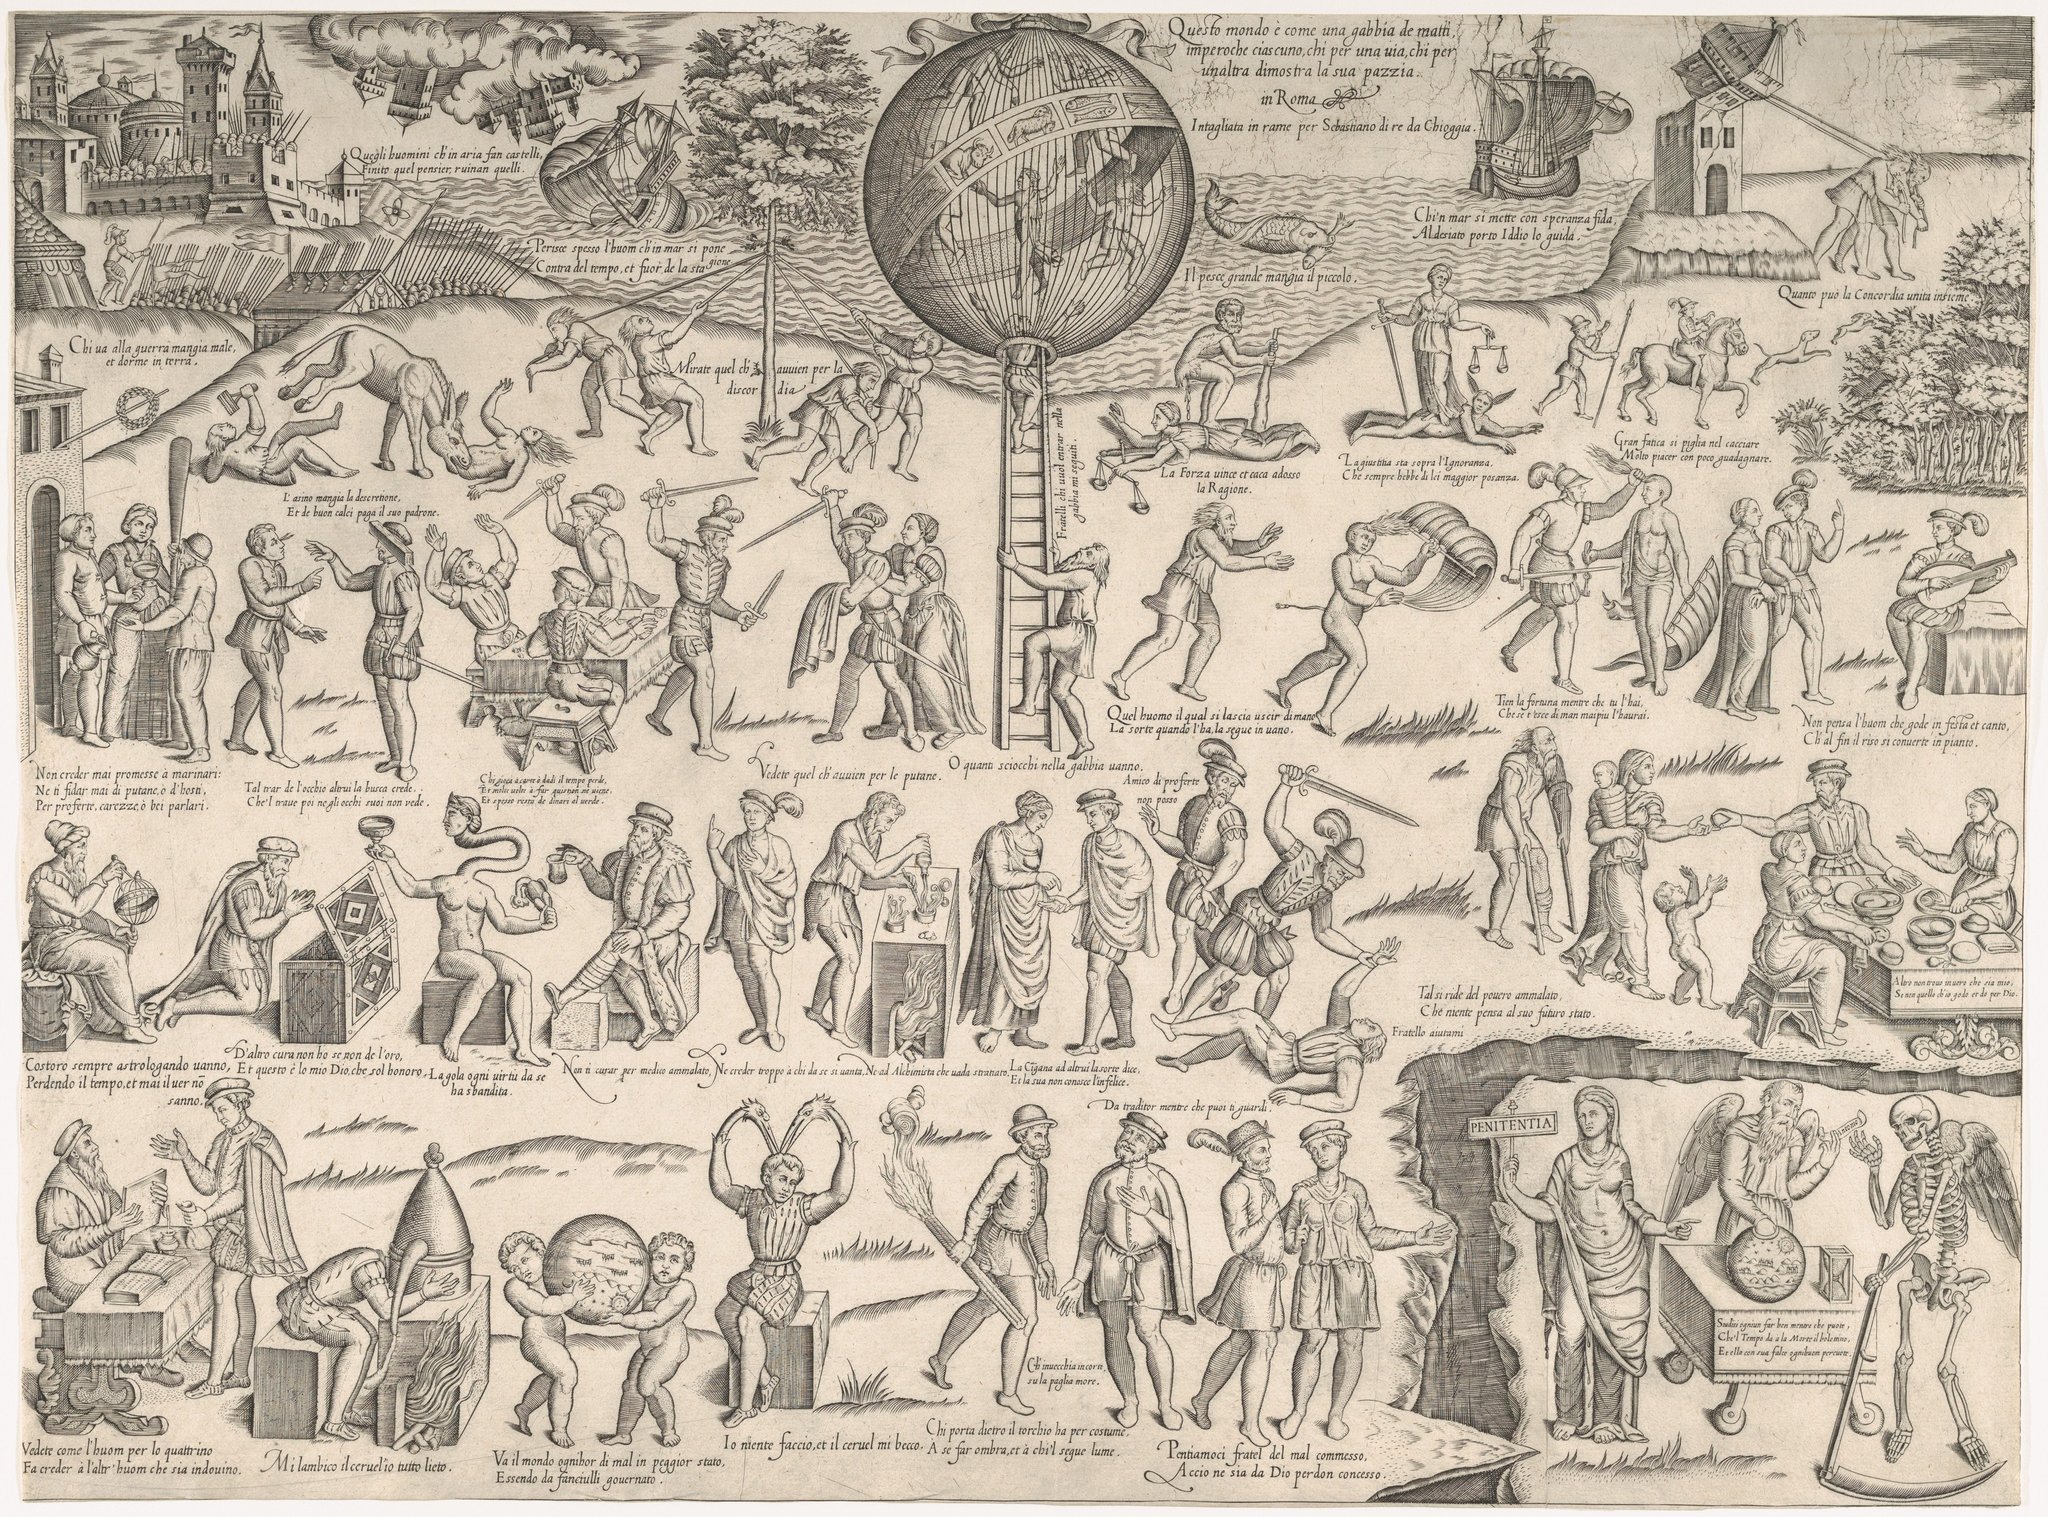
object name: print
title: The Cage of Fools (La gabbia de' matti)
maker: sebastiano di re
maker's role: artist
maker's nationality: italian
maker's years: 1557-1563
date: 1557-1563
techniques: engraving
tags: skeletons,children,men,women,donkeys,ships